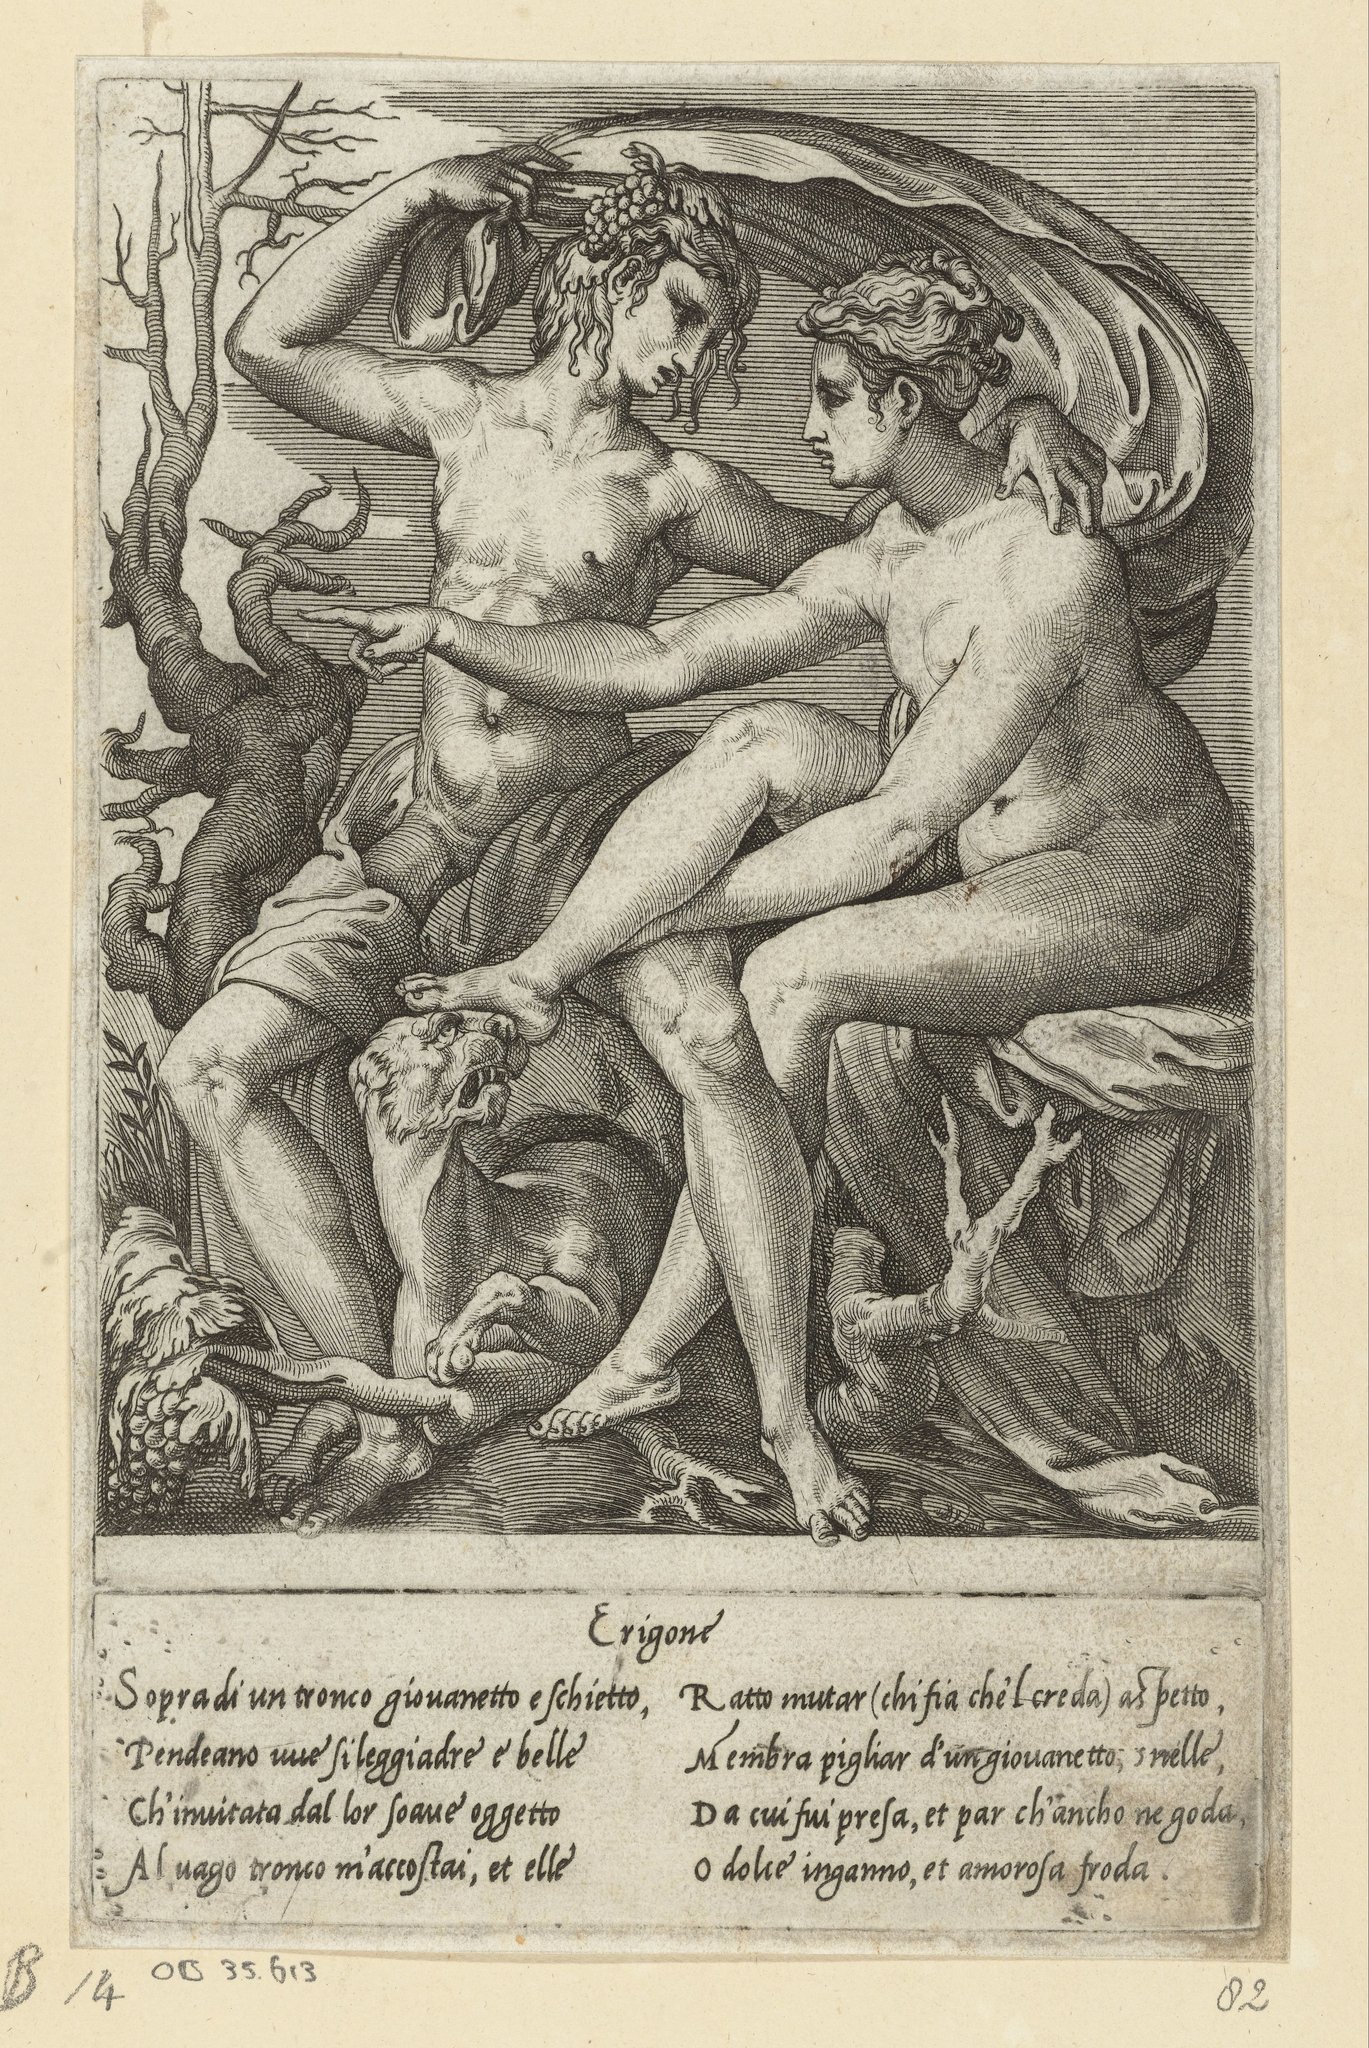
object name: print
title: Loves of the Gods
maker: giovanni jacopo caraglio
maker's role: goldsmith, print maker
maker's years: 1500-1565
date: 1515-1565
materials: paper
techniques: engraving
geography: italy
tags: erigone and bacchus, the latter possibly in the shape of a bunch of grapes, love-affairs of bacchus ~ females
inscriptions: collector's mark: Lugt 240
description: Bacchus en Erigone zitten naakt en met hun benen verstrengeld. Bij hun voeten ligt een leeuw. In de ondermarge Italiaans vers in twee kolommen.